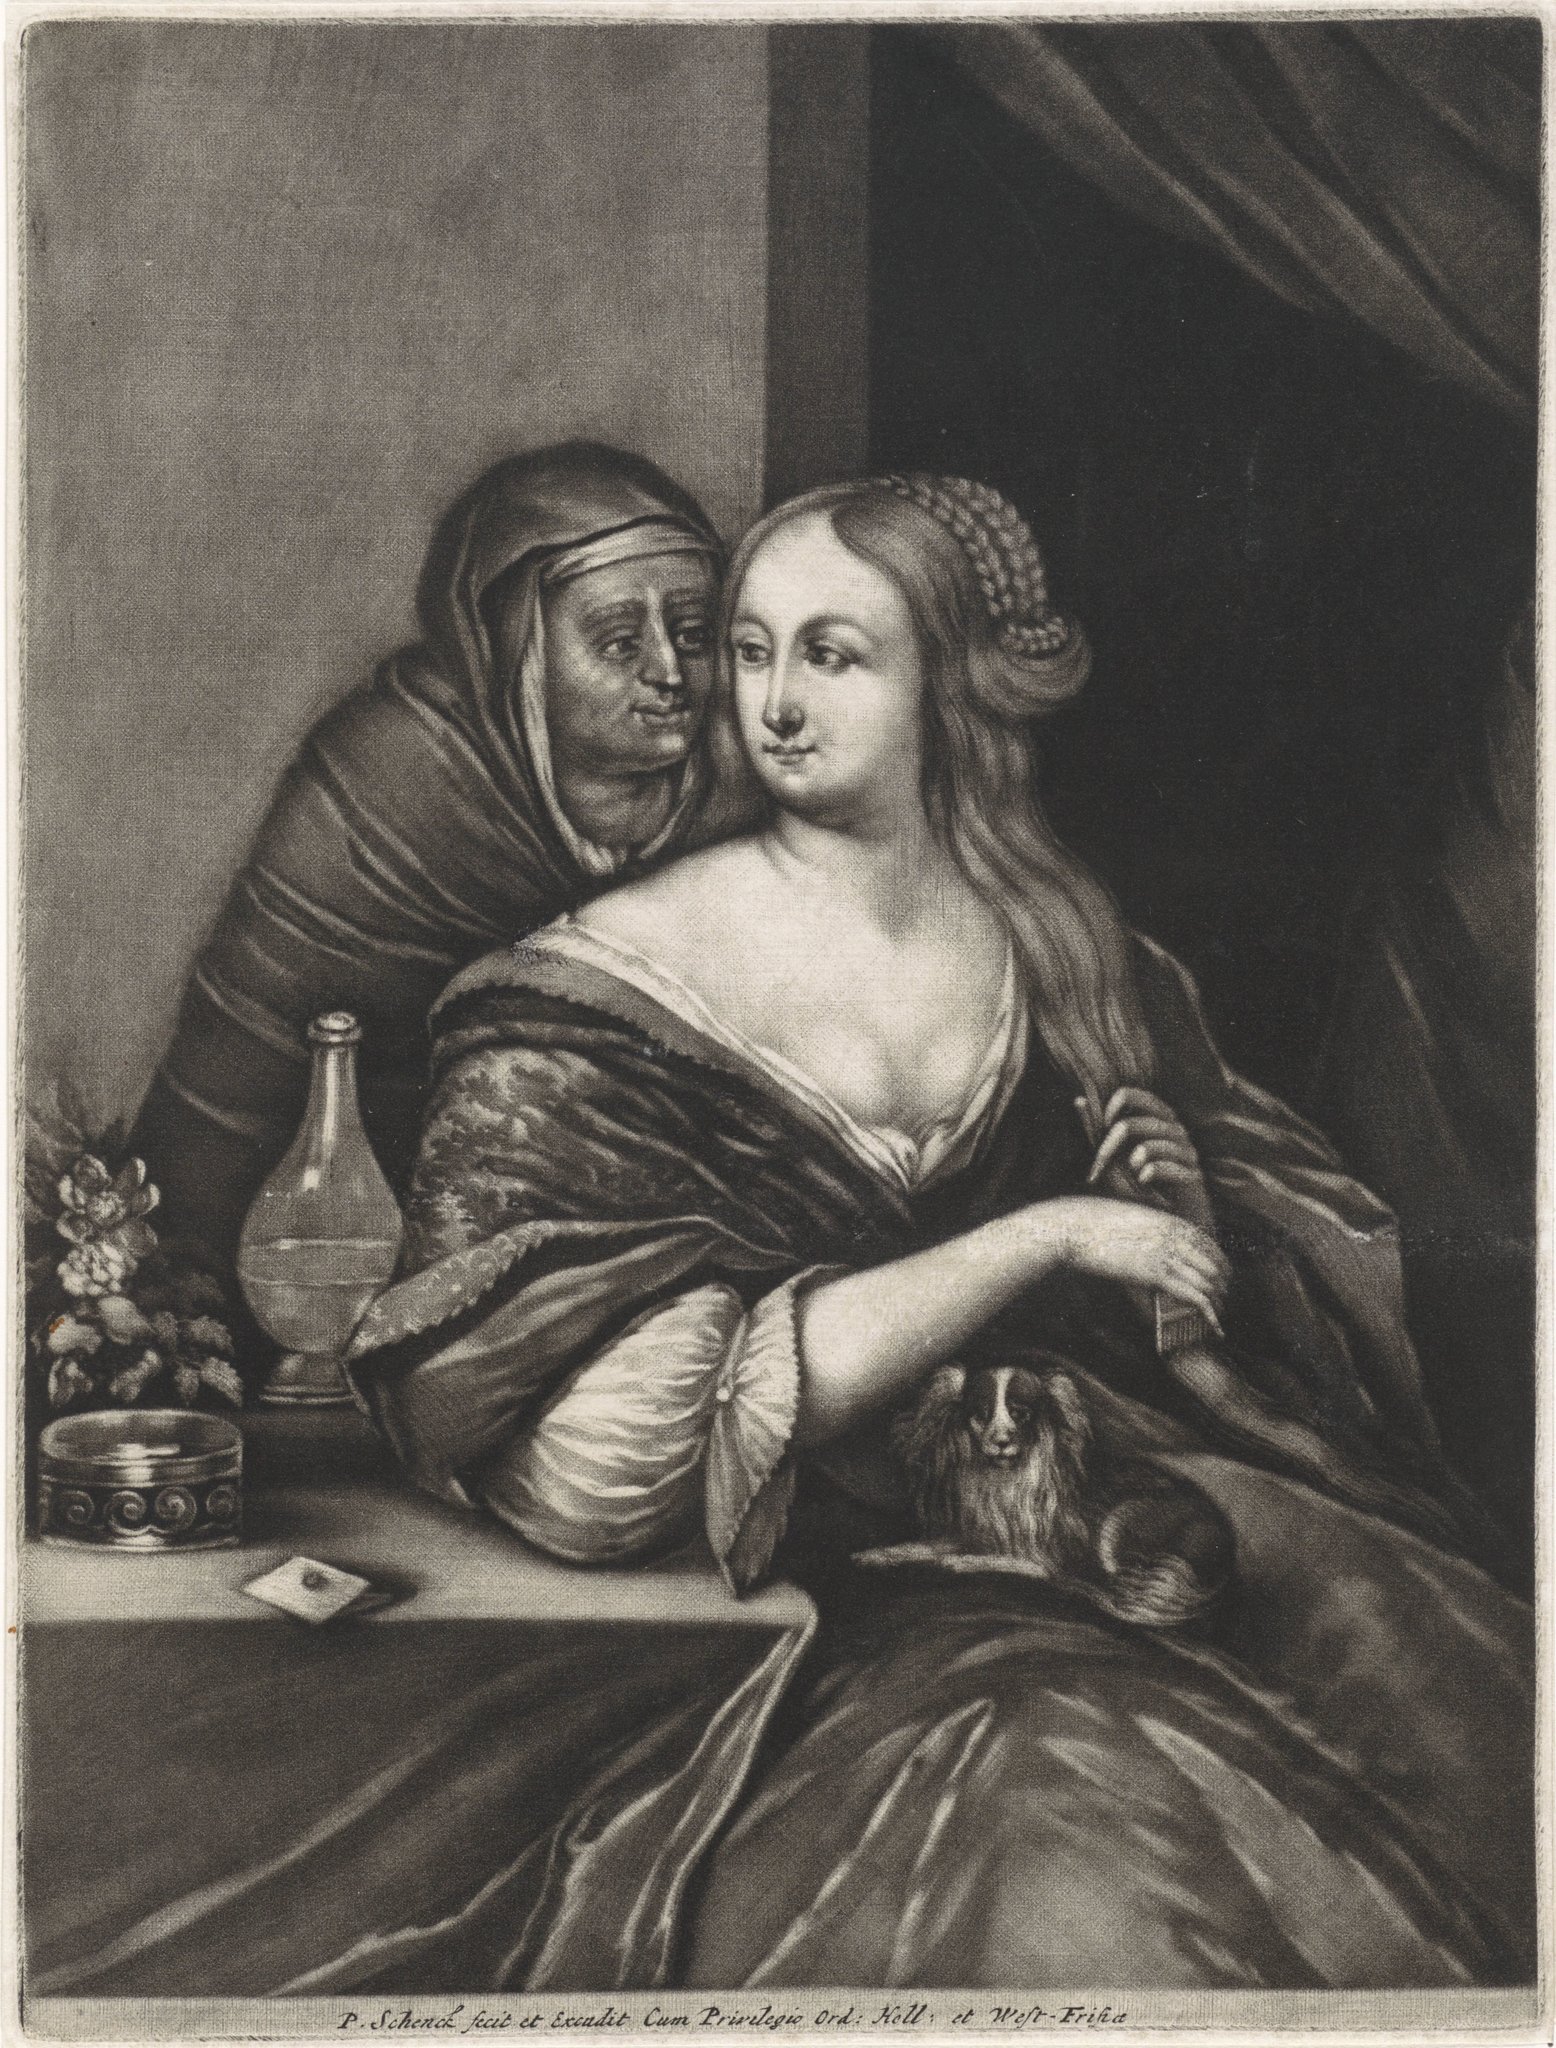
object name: print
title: Jonge vrouw en een koppelaarster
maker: pieter schenk (i)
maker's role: print maker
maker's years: 1660-1711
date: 1670-1713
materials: paper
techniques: engraving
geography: amsterdam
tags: madam (brothel scene), dog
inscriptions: collector's mark: Lugt 2228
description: Een jonge vrouw kamt haar haren, op haar schoot een hondje. Achter haar een oude vrouw die naar het oor van de jonge vrouw toe buigt.